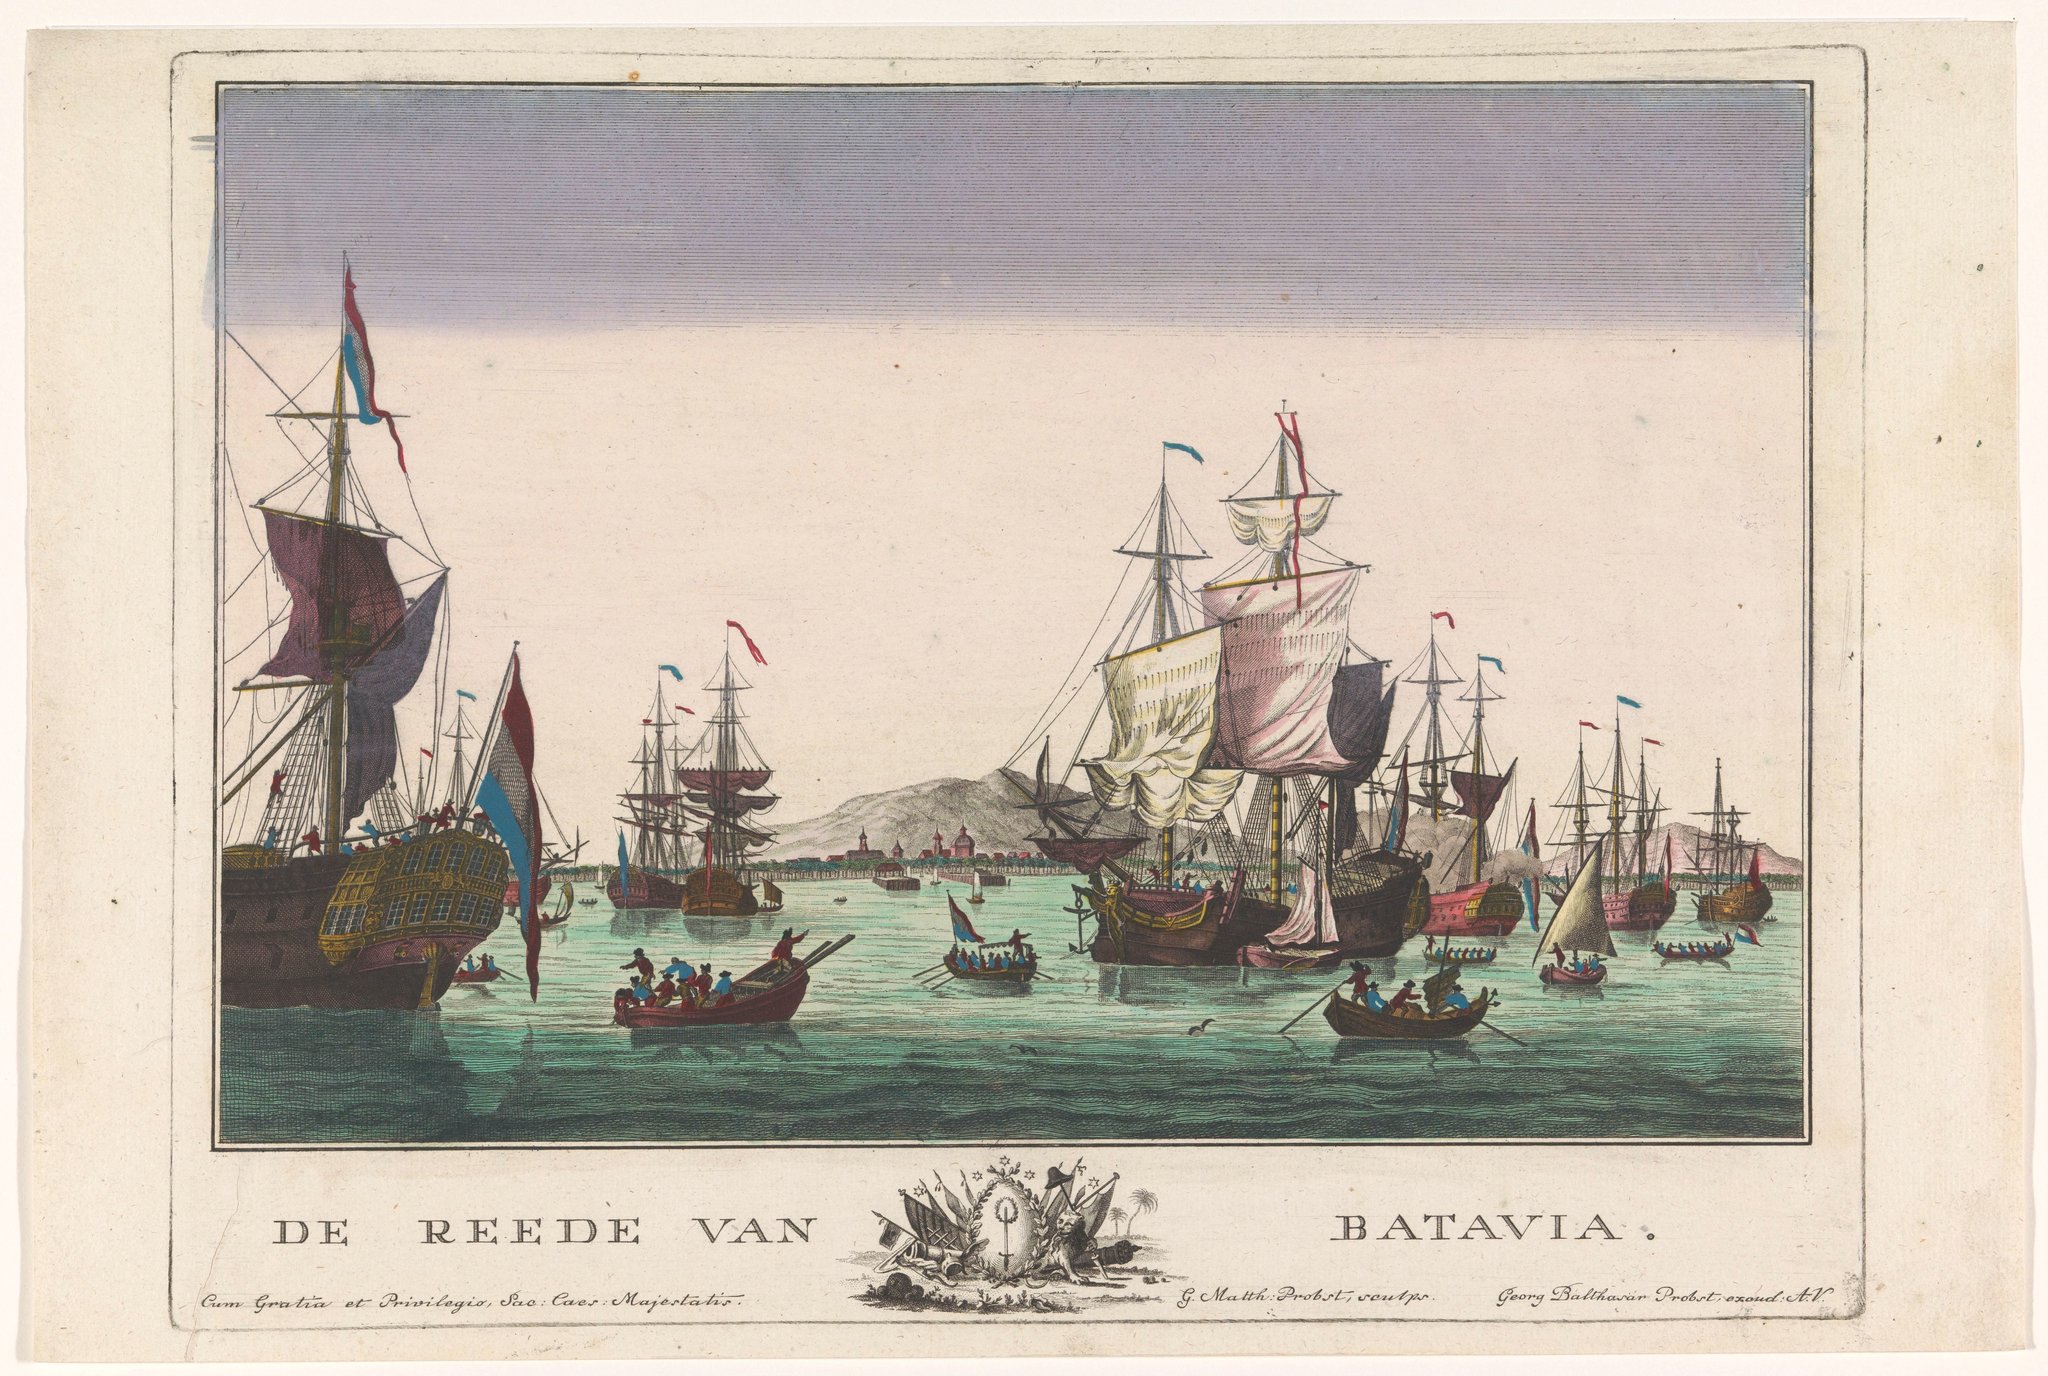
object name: opticaprent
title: Havengezichten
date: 1742-1801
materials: paper, watercolor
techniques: brush, etching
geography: augsburg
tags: harbour, sailing-ship, sailing-boat, rowing-boat, canoe, etc., sea (seascape) (+ landscape with figures, staffage), batavia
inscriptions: watermark, collector's mark: Lugt 2760